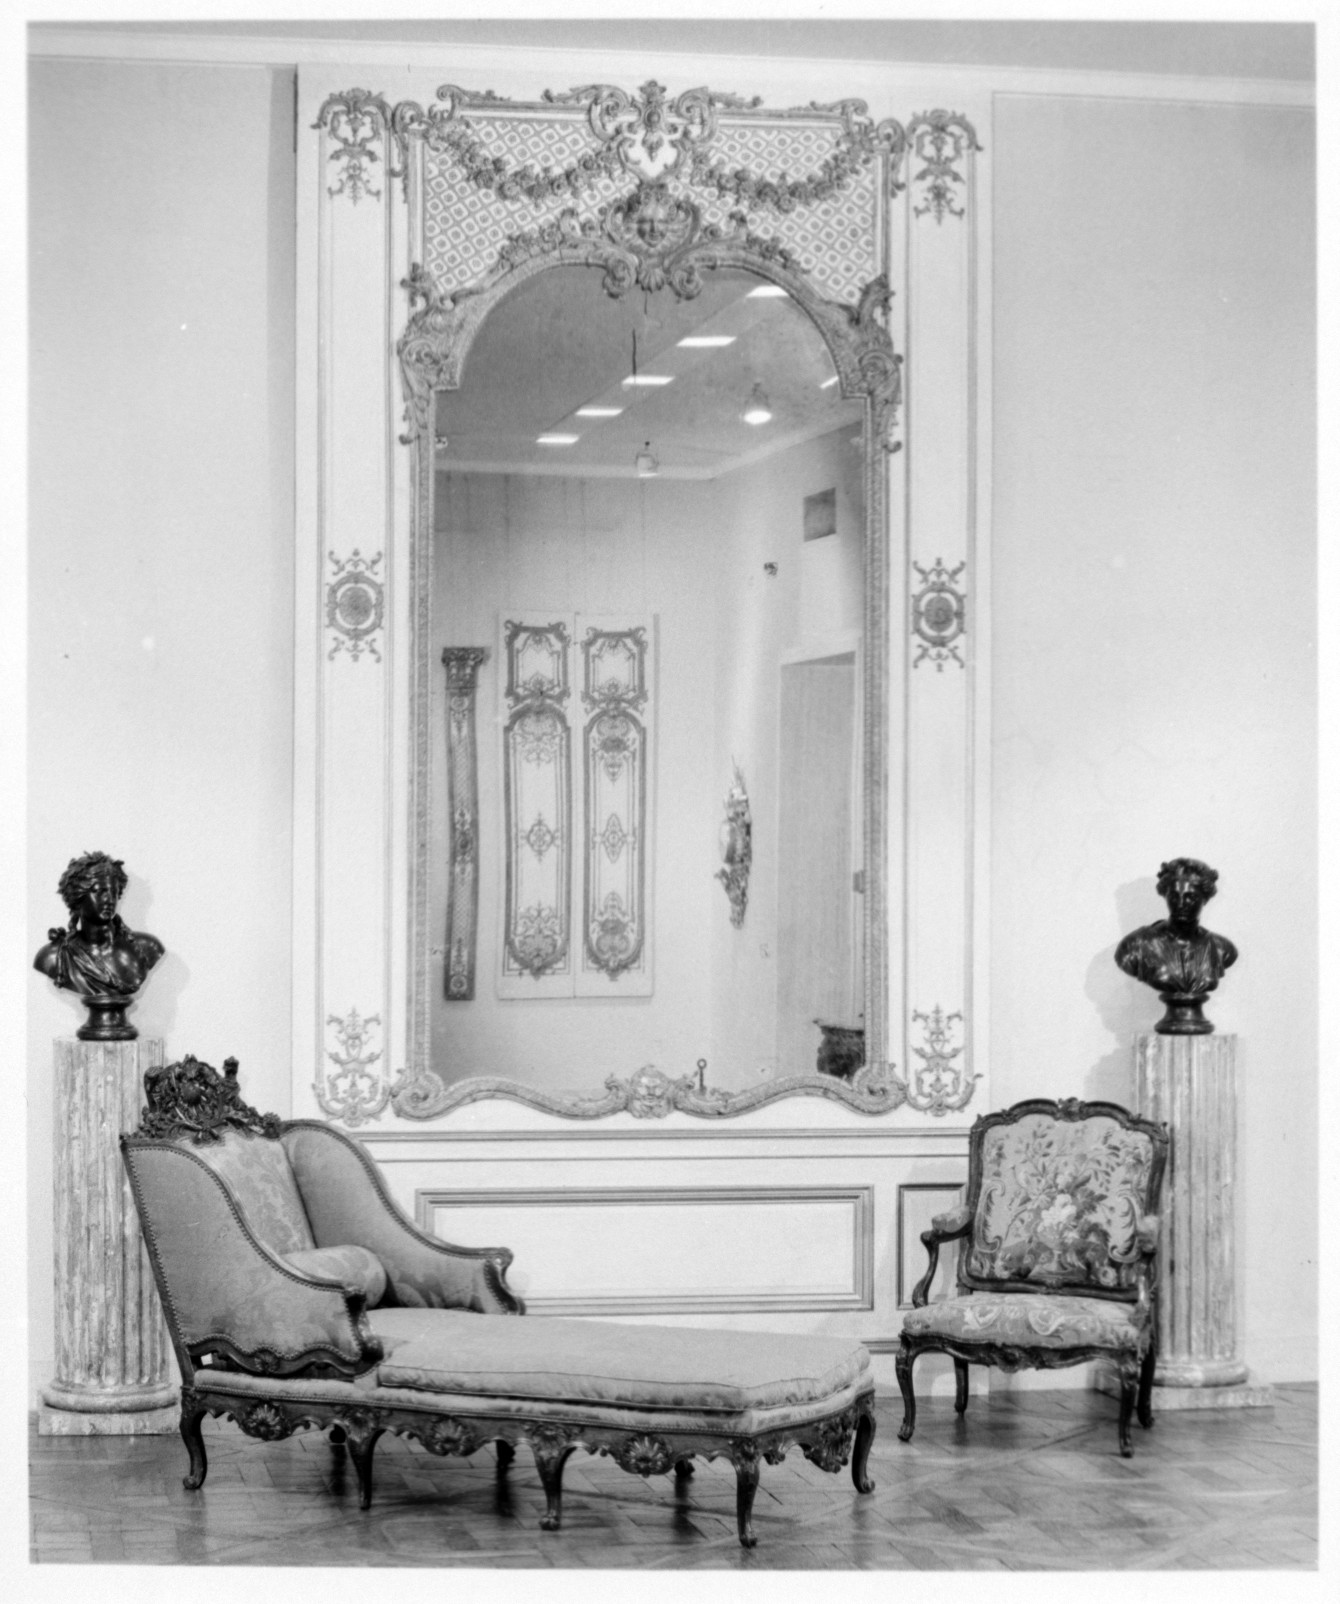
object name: pier glass frame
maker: jules degoullons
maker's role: maker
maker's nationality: french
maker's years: 1671-1737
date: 1724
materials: wood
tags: masks,garlands